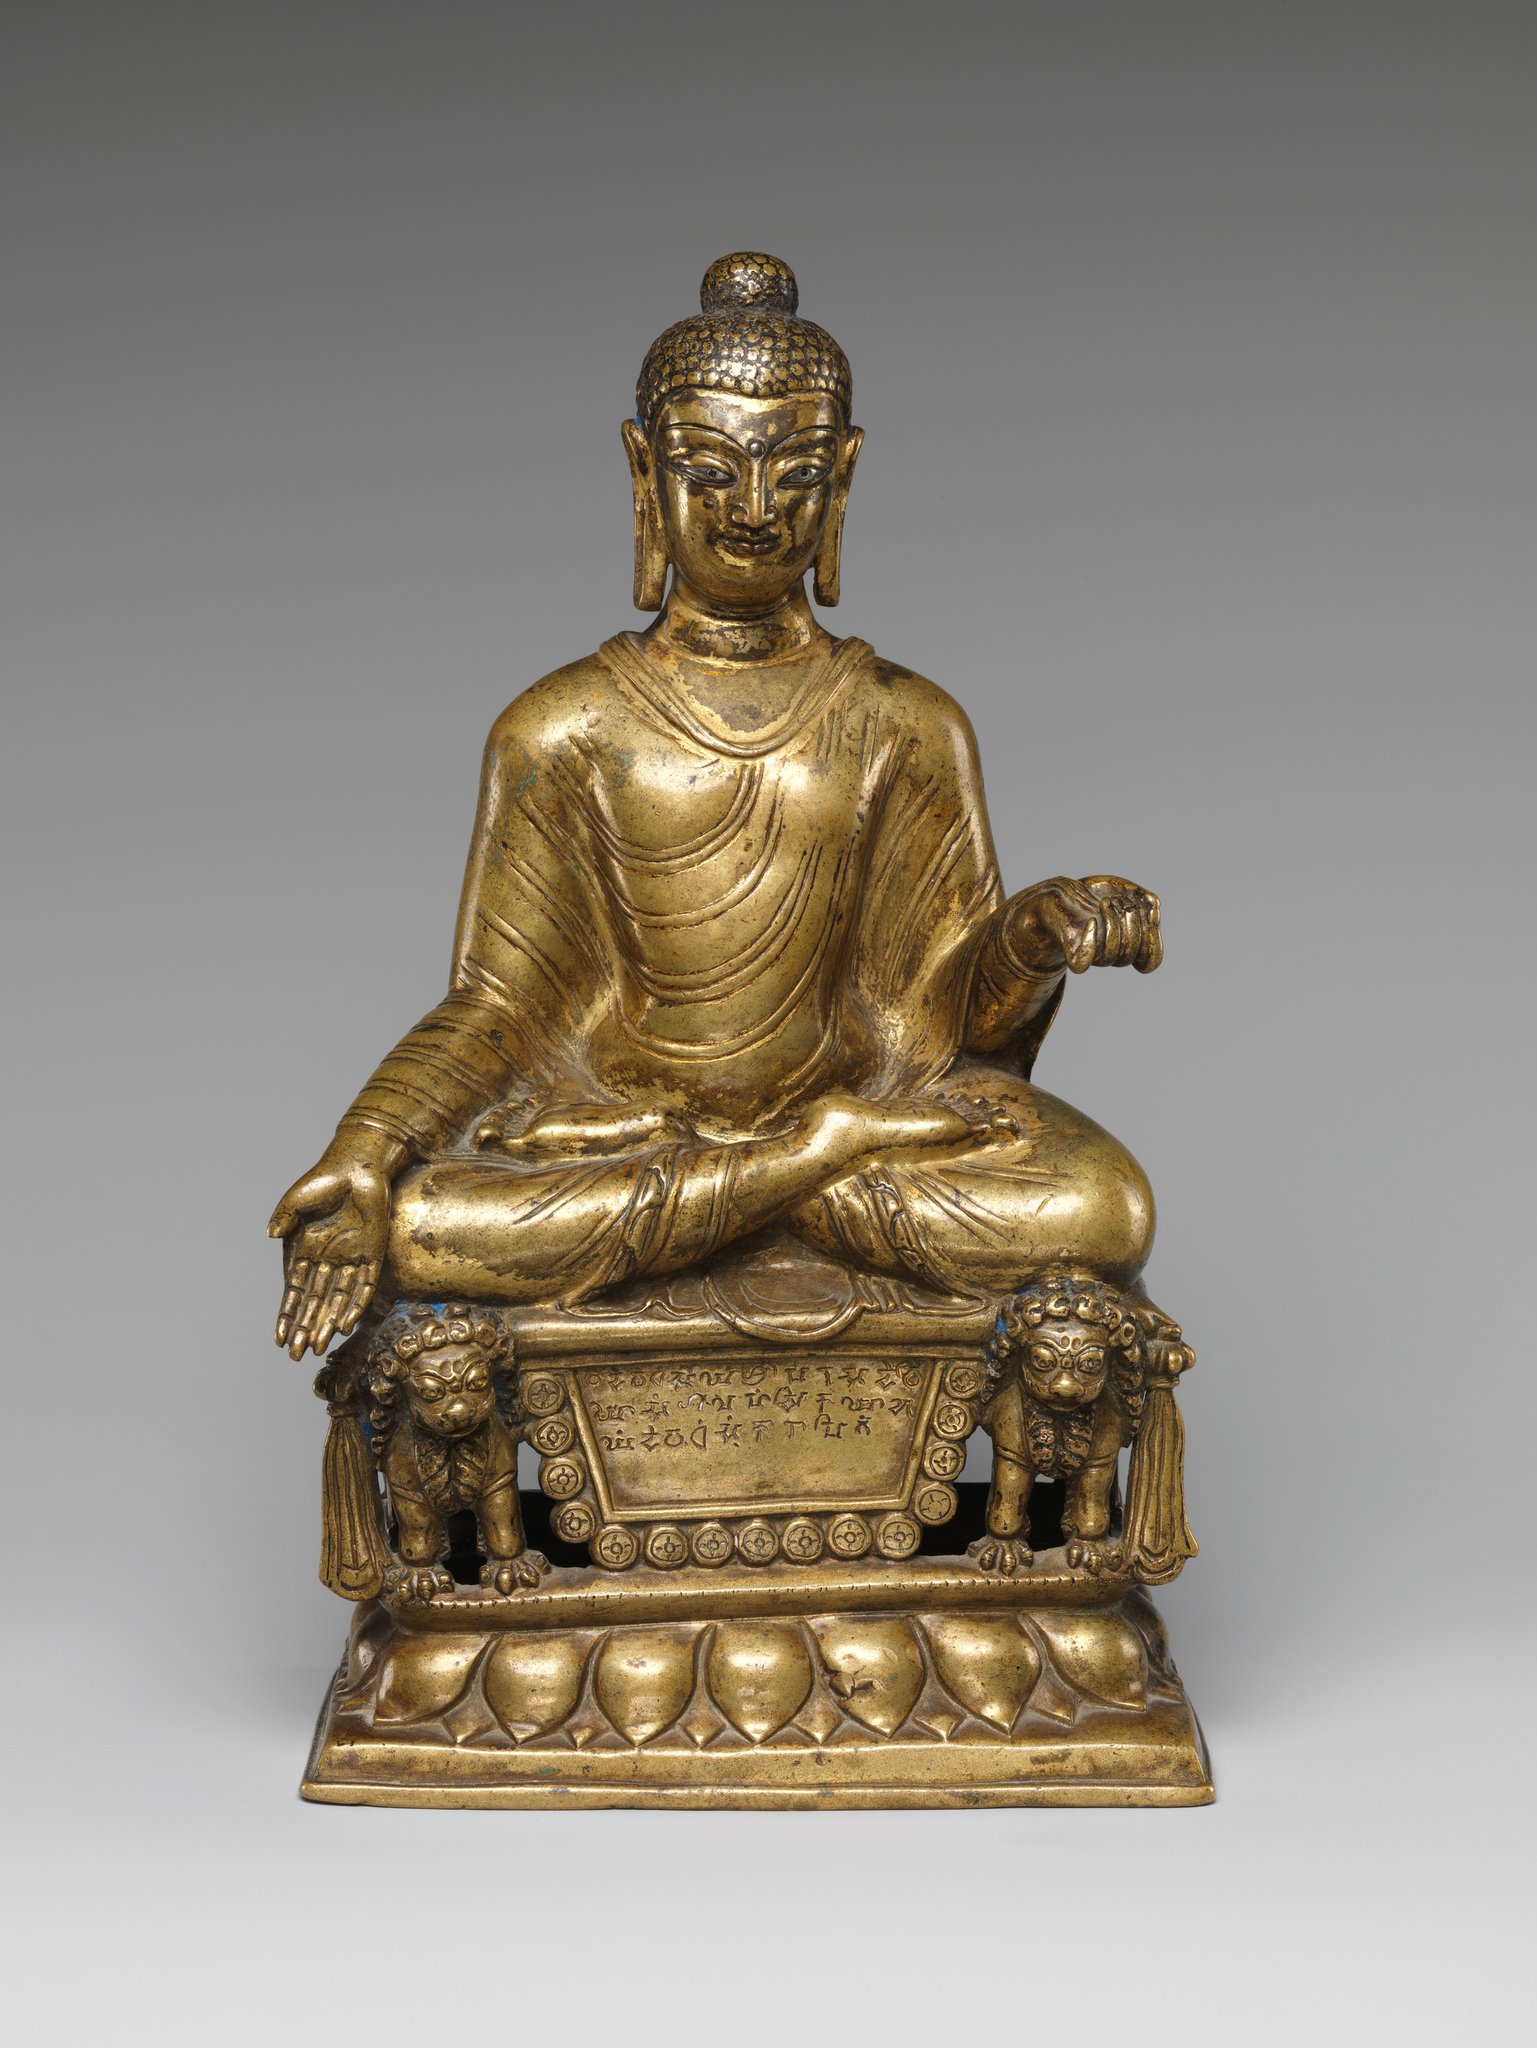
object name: figure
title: Enthroned Buddha Granting Boons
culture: pakistani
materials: brass, copper, gilt, silver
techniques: inlay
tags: buddhism,buddha